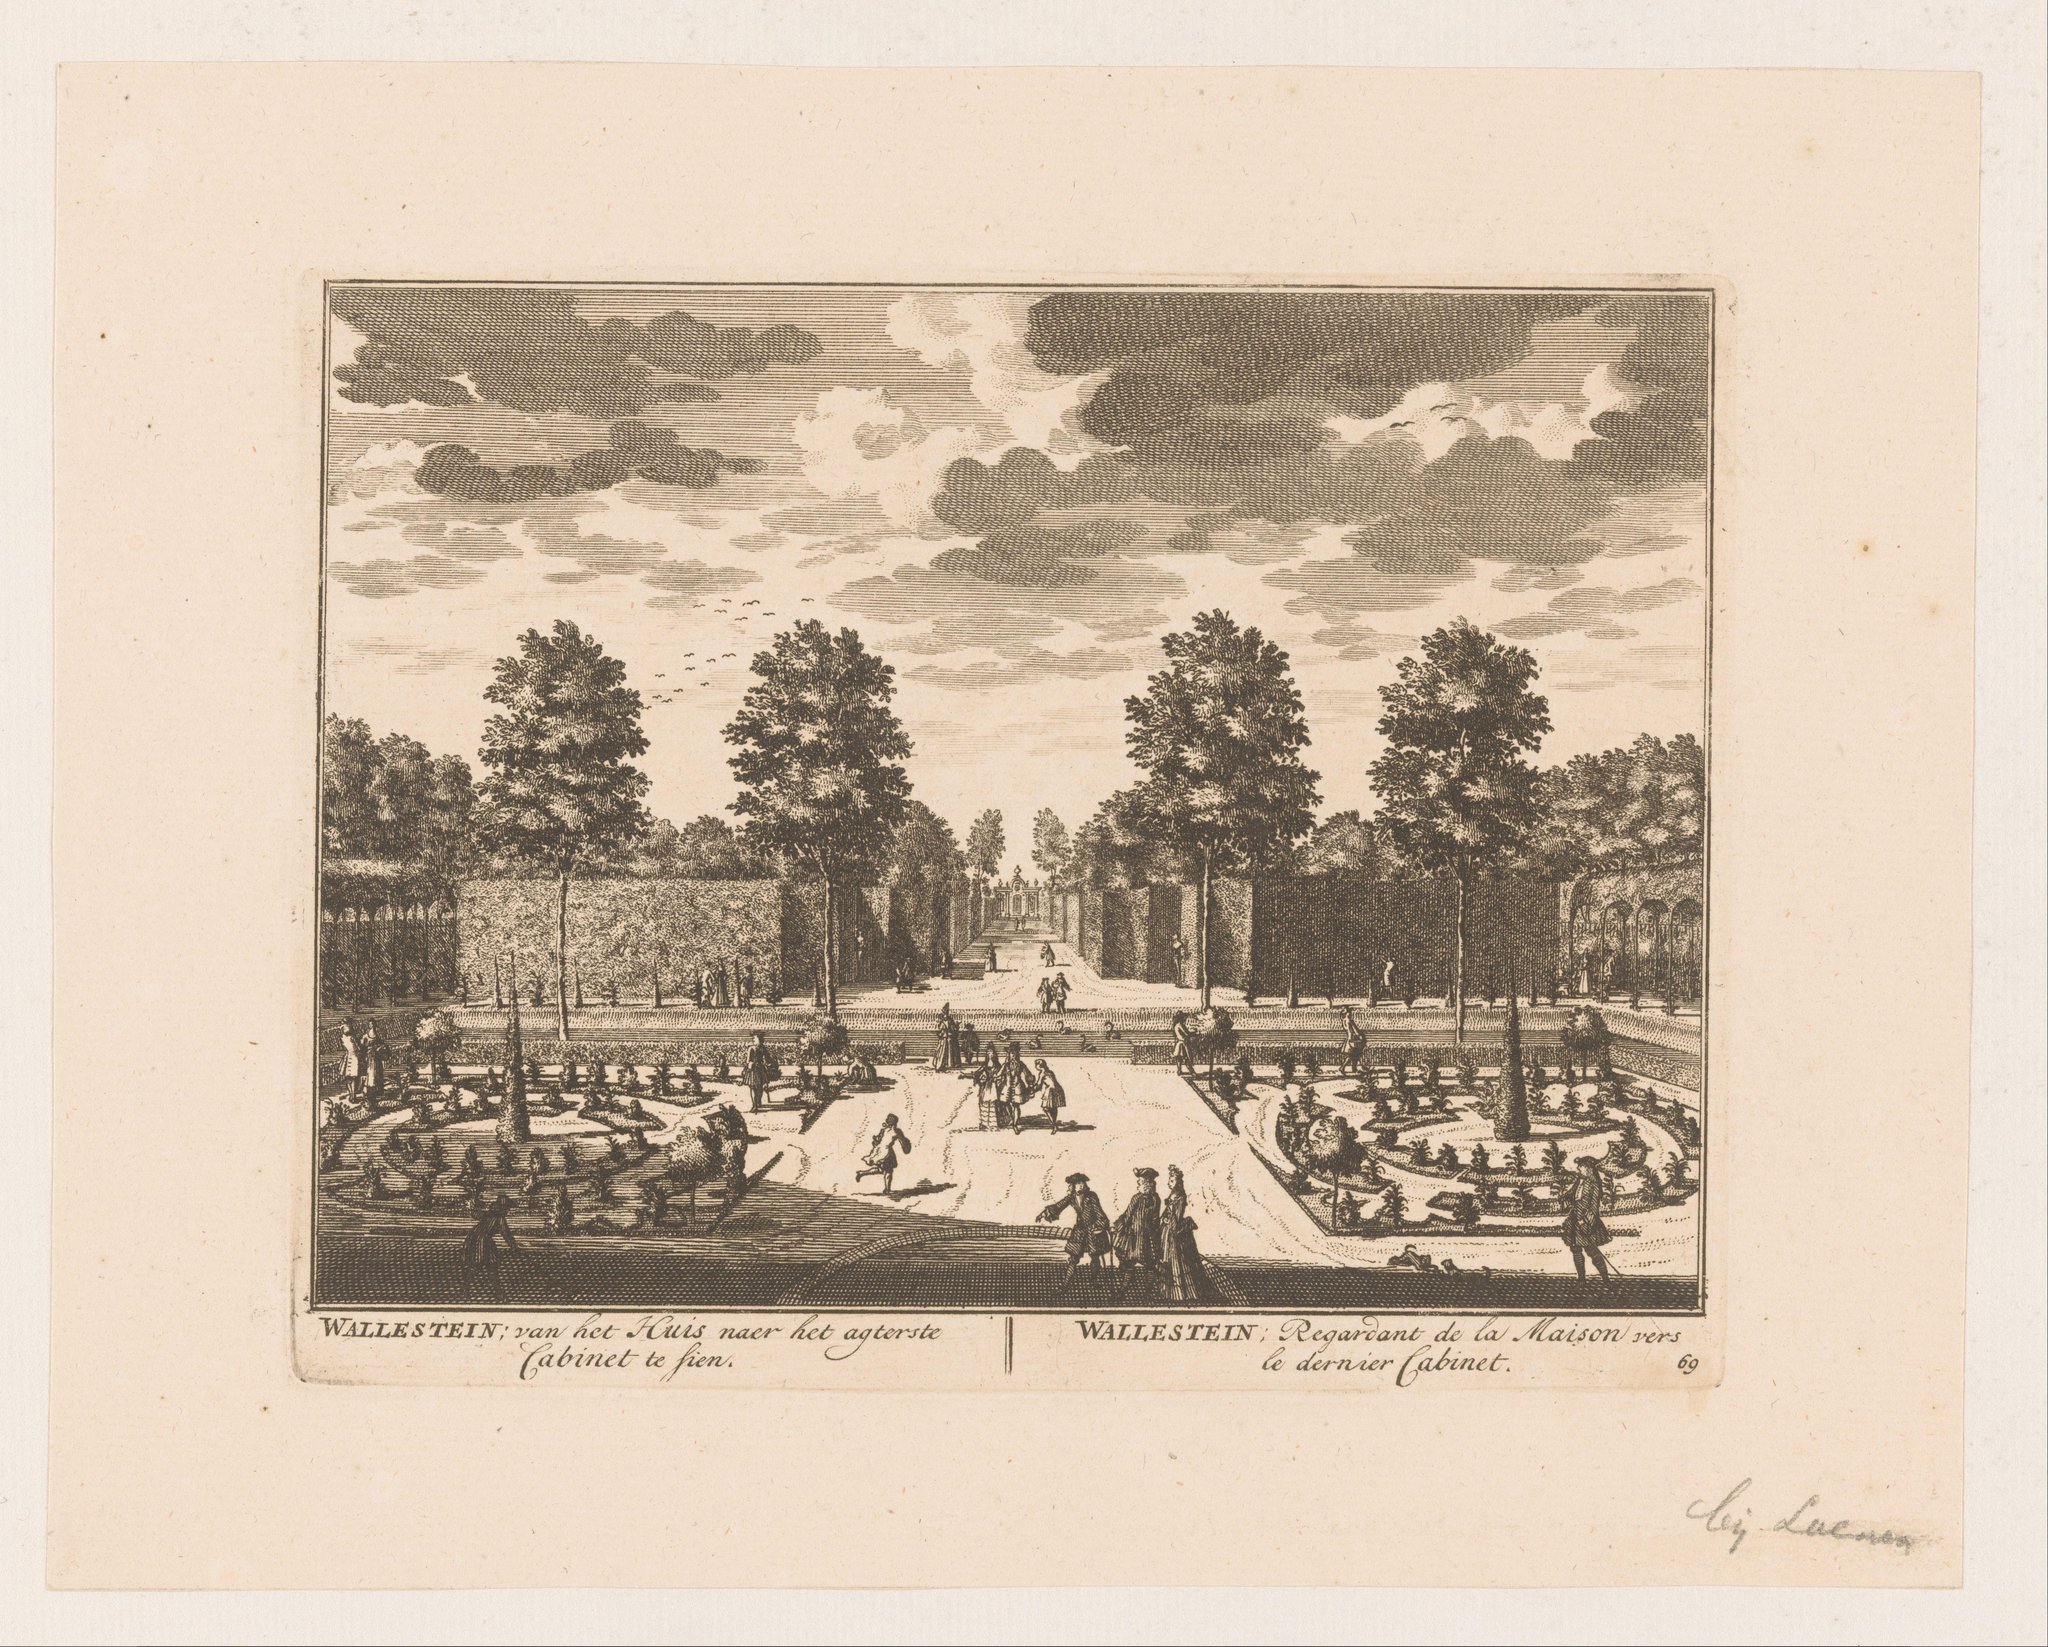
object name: print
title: Gezicht vanuit huis Wallestein richting tuin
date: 1719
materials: paper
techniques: etching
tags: rural housing, e.g. country-house, villa, cottage, french or architectonic garden; formal garden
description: Prent uit: De zegepraalende Vecht, vertoonende verscheidene gesichten van lustplaatsen, heeren huysen en dorpen, beginnende van Uitrecht en met Muyden besluytende. Amsterdam: Wed. Nicolaes Visscher, 1719.